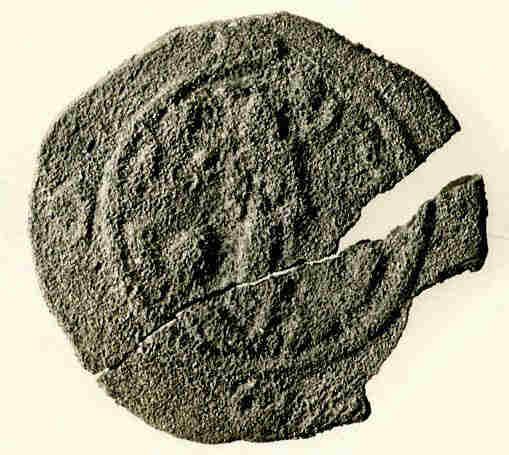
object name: coin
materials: silver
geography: iran